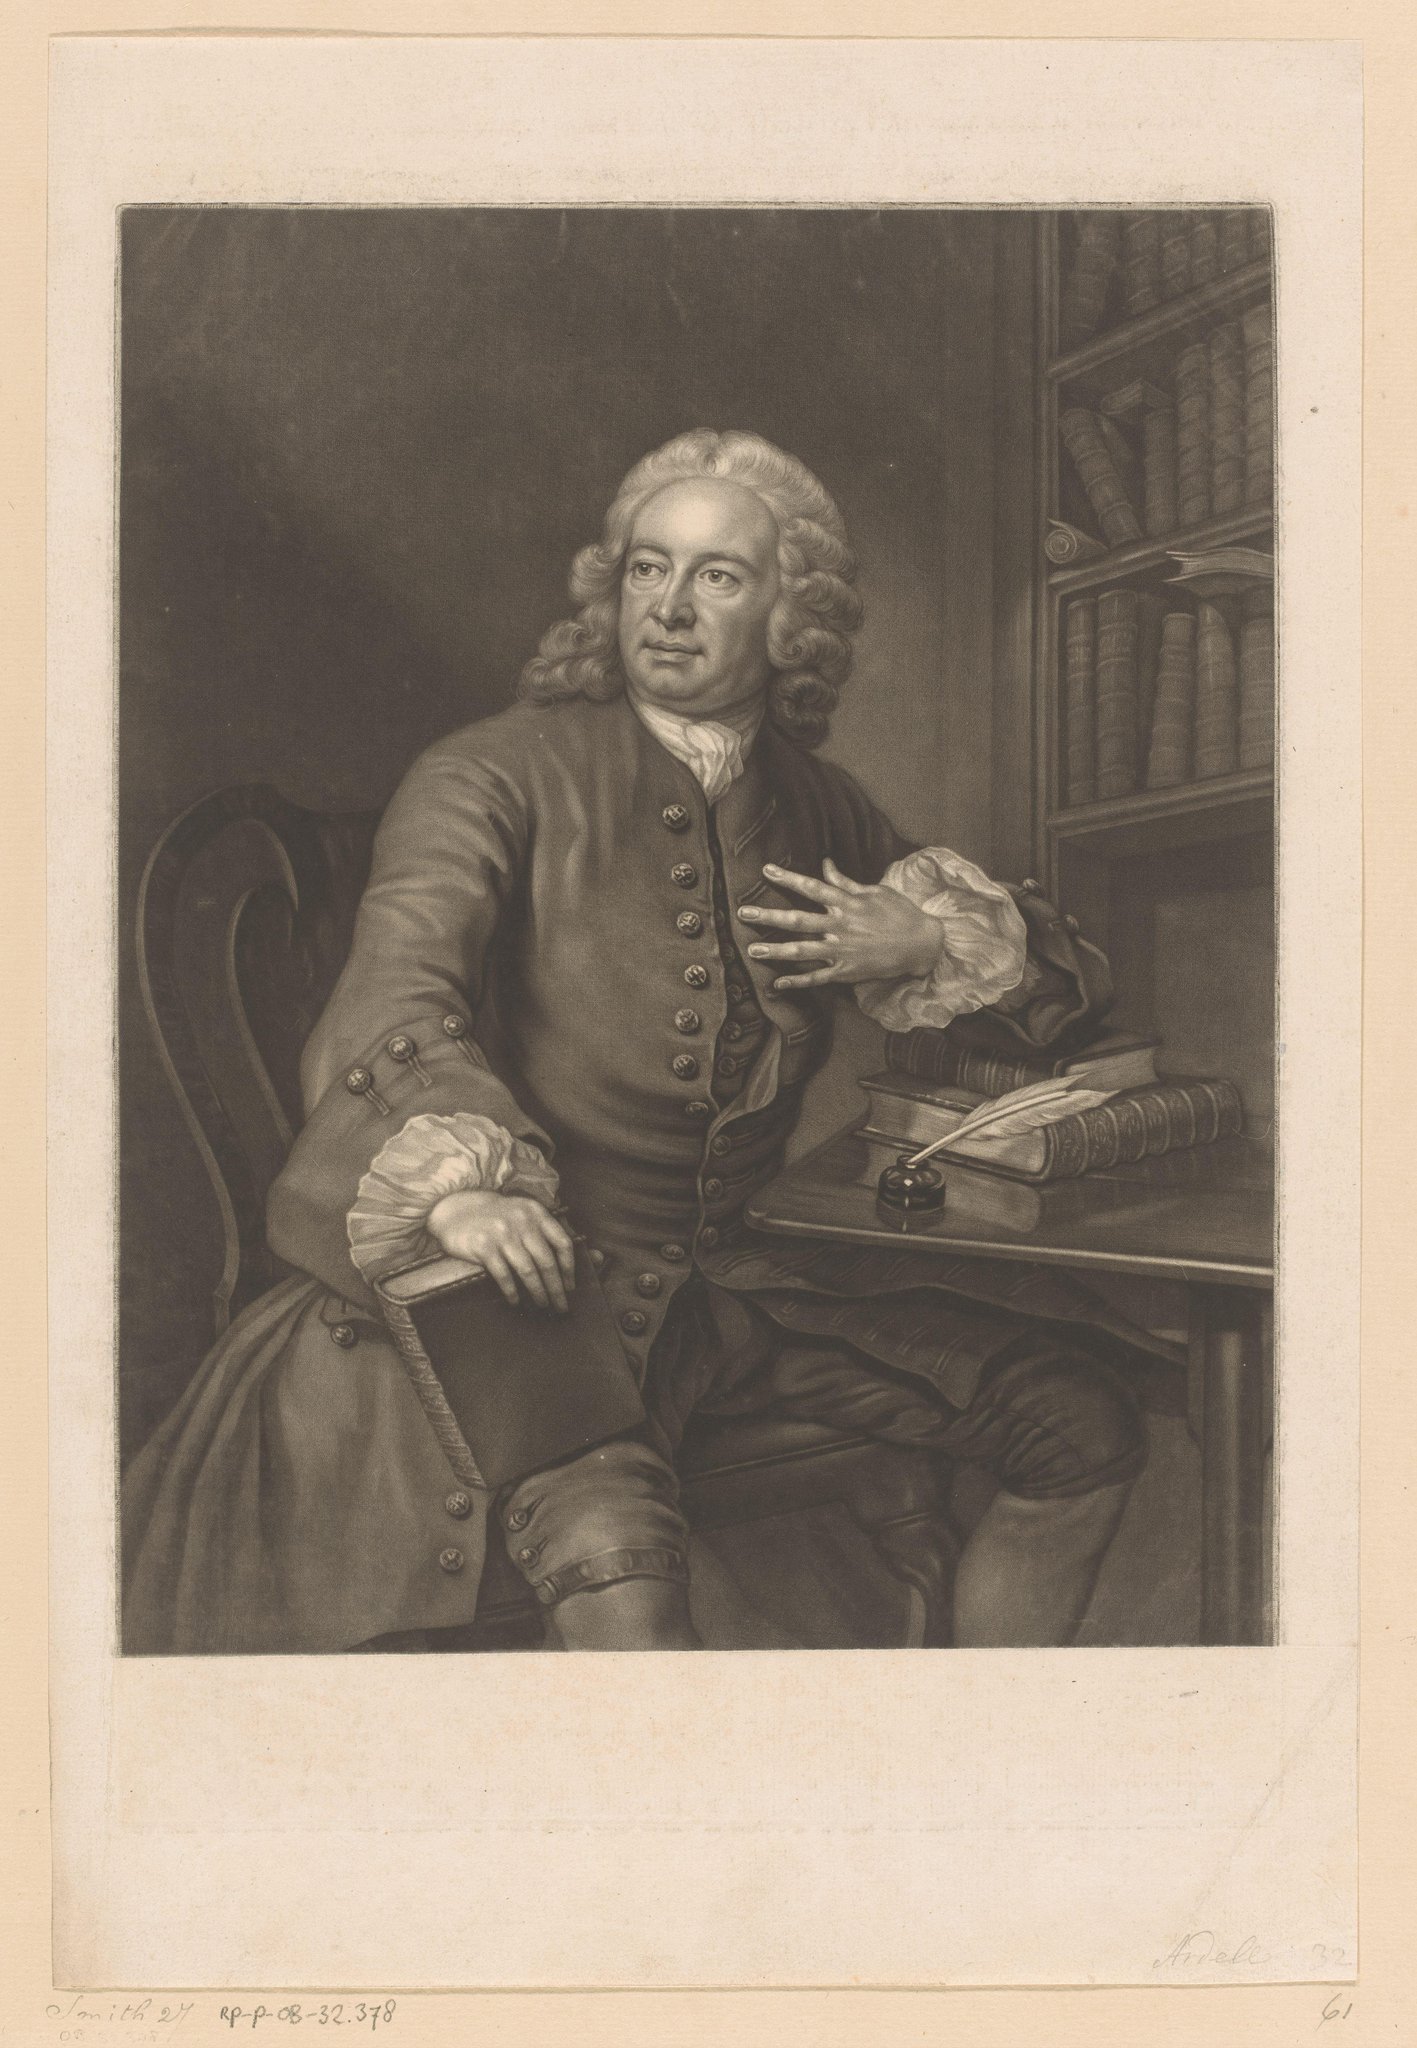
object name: print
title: Portret van Archibald Bower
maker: james mcardell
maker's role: print maker, publisher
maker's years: 1728-1765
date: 1750-1765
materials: paper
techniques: mezzotint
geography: london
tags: history and archaeology (+ portrait of scholar, scientist), historical persons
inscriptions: collector's mark: Lugt 240